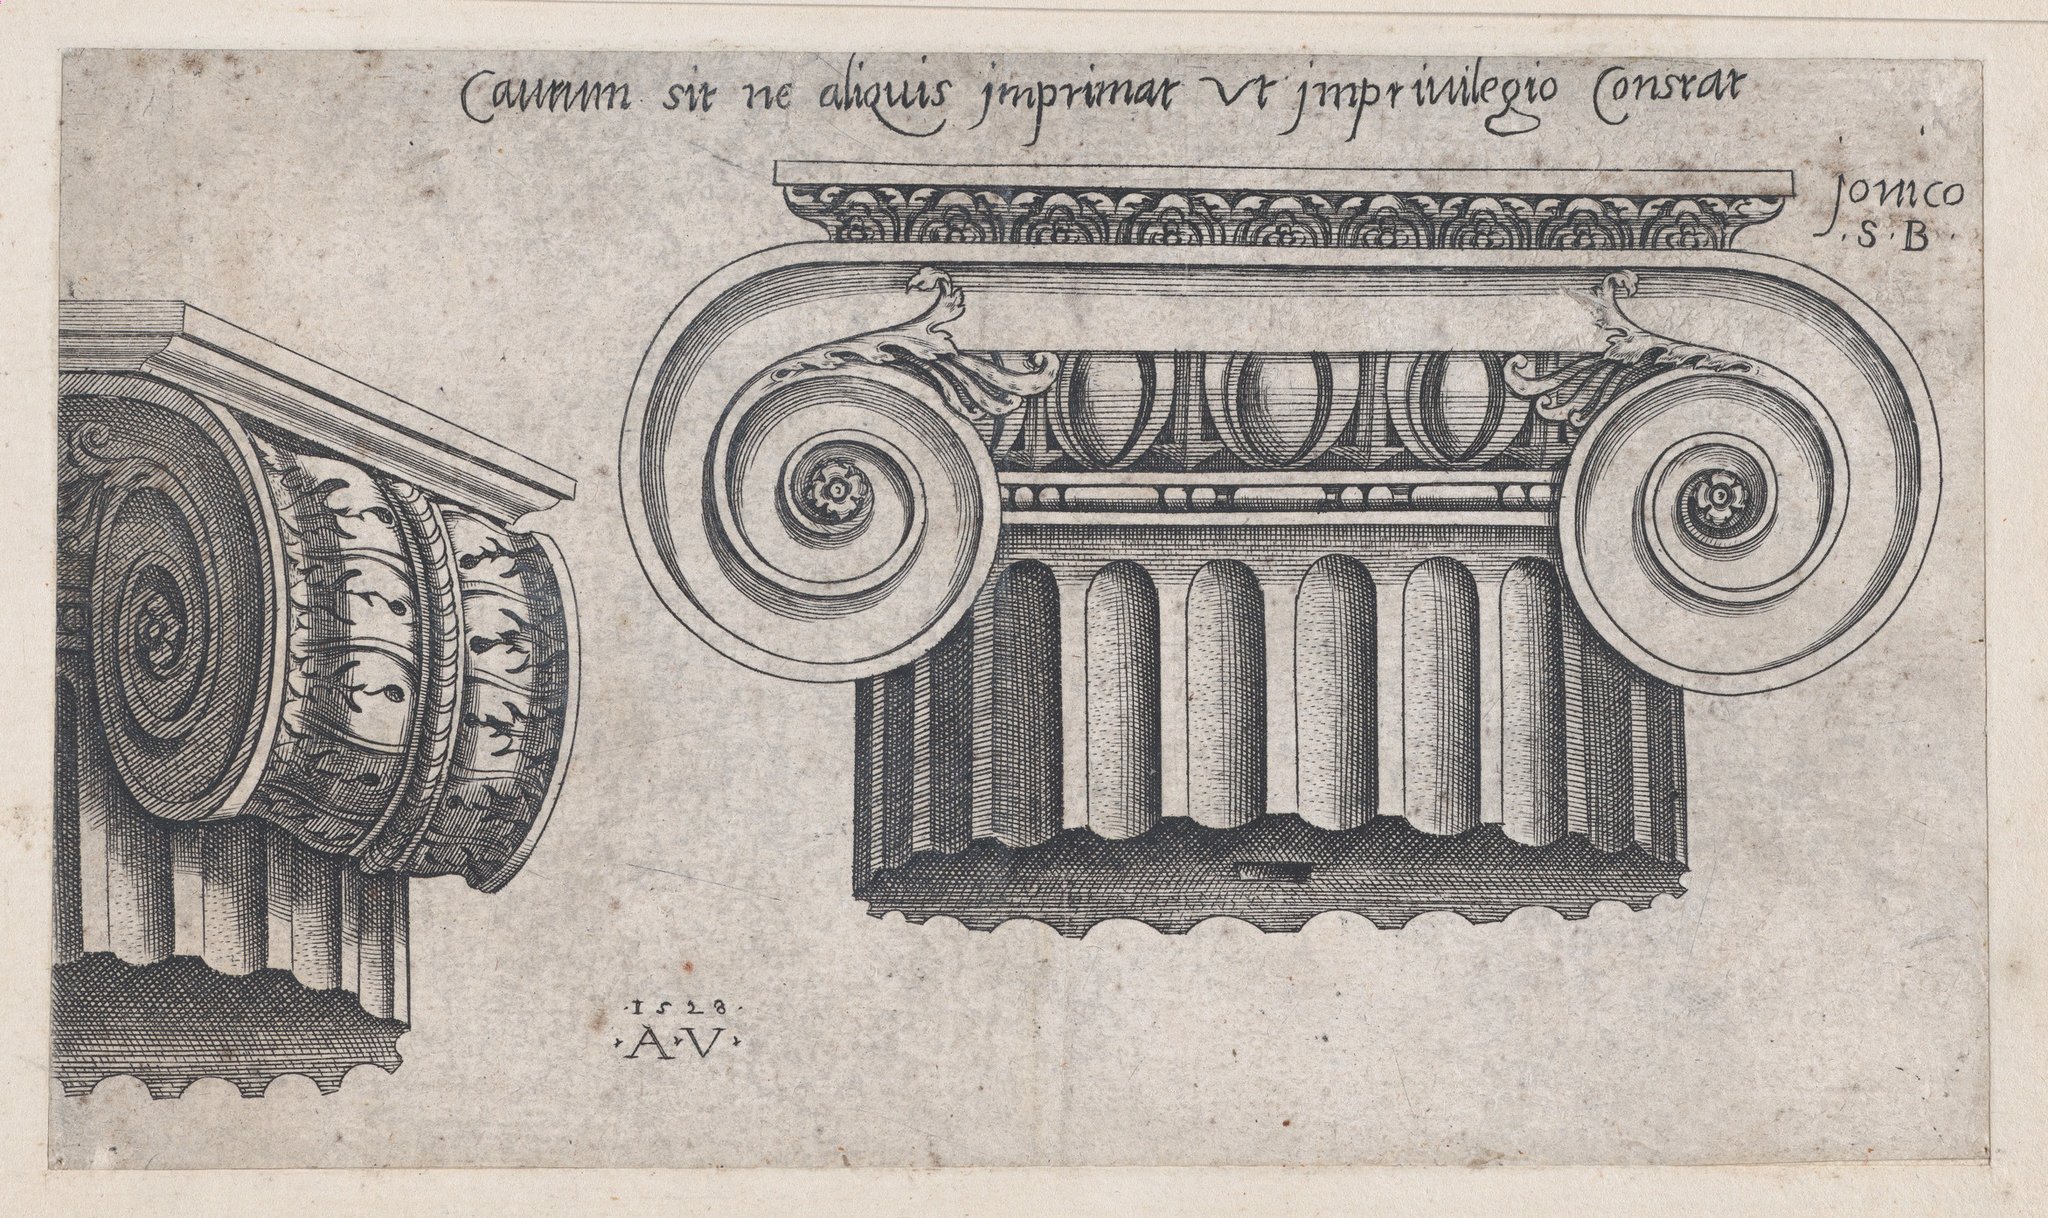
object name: print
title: Ionic Capital, from "Speculum Romanae Magnificentiae"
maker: agostino veneziano (agostino dei musi)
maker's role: artist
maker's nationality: italian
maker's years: 1490-1536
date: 1528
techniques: engraving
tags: capitals